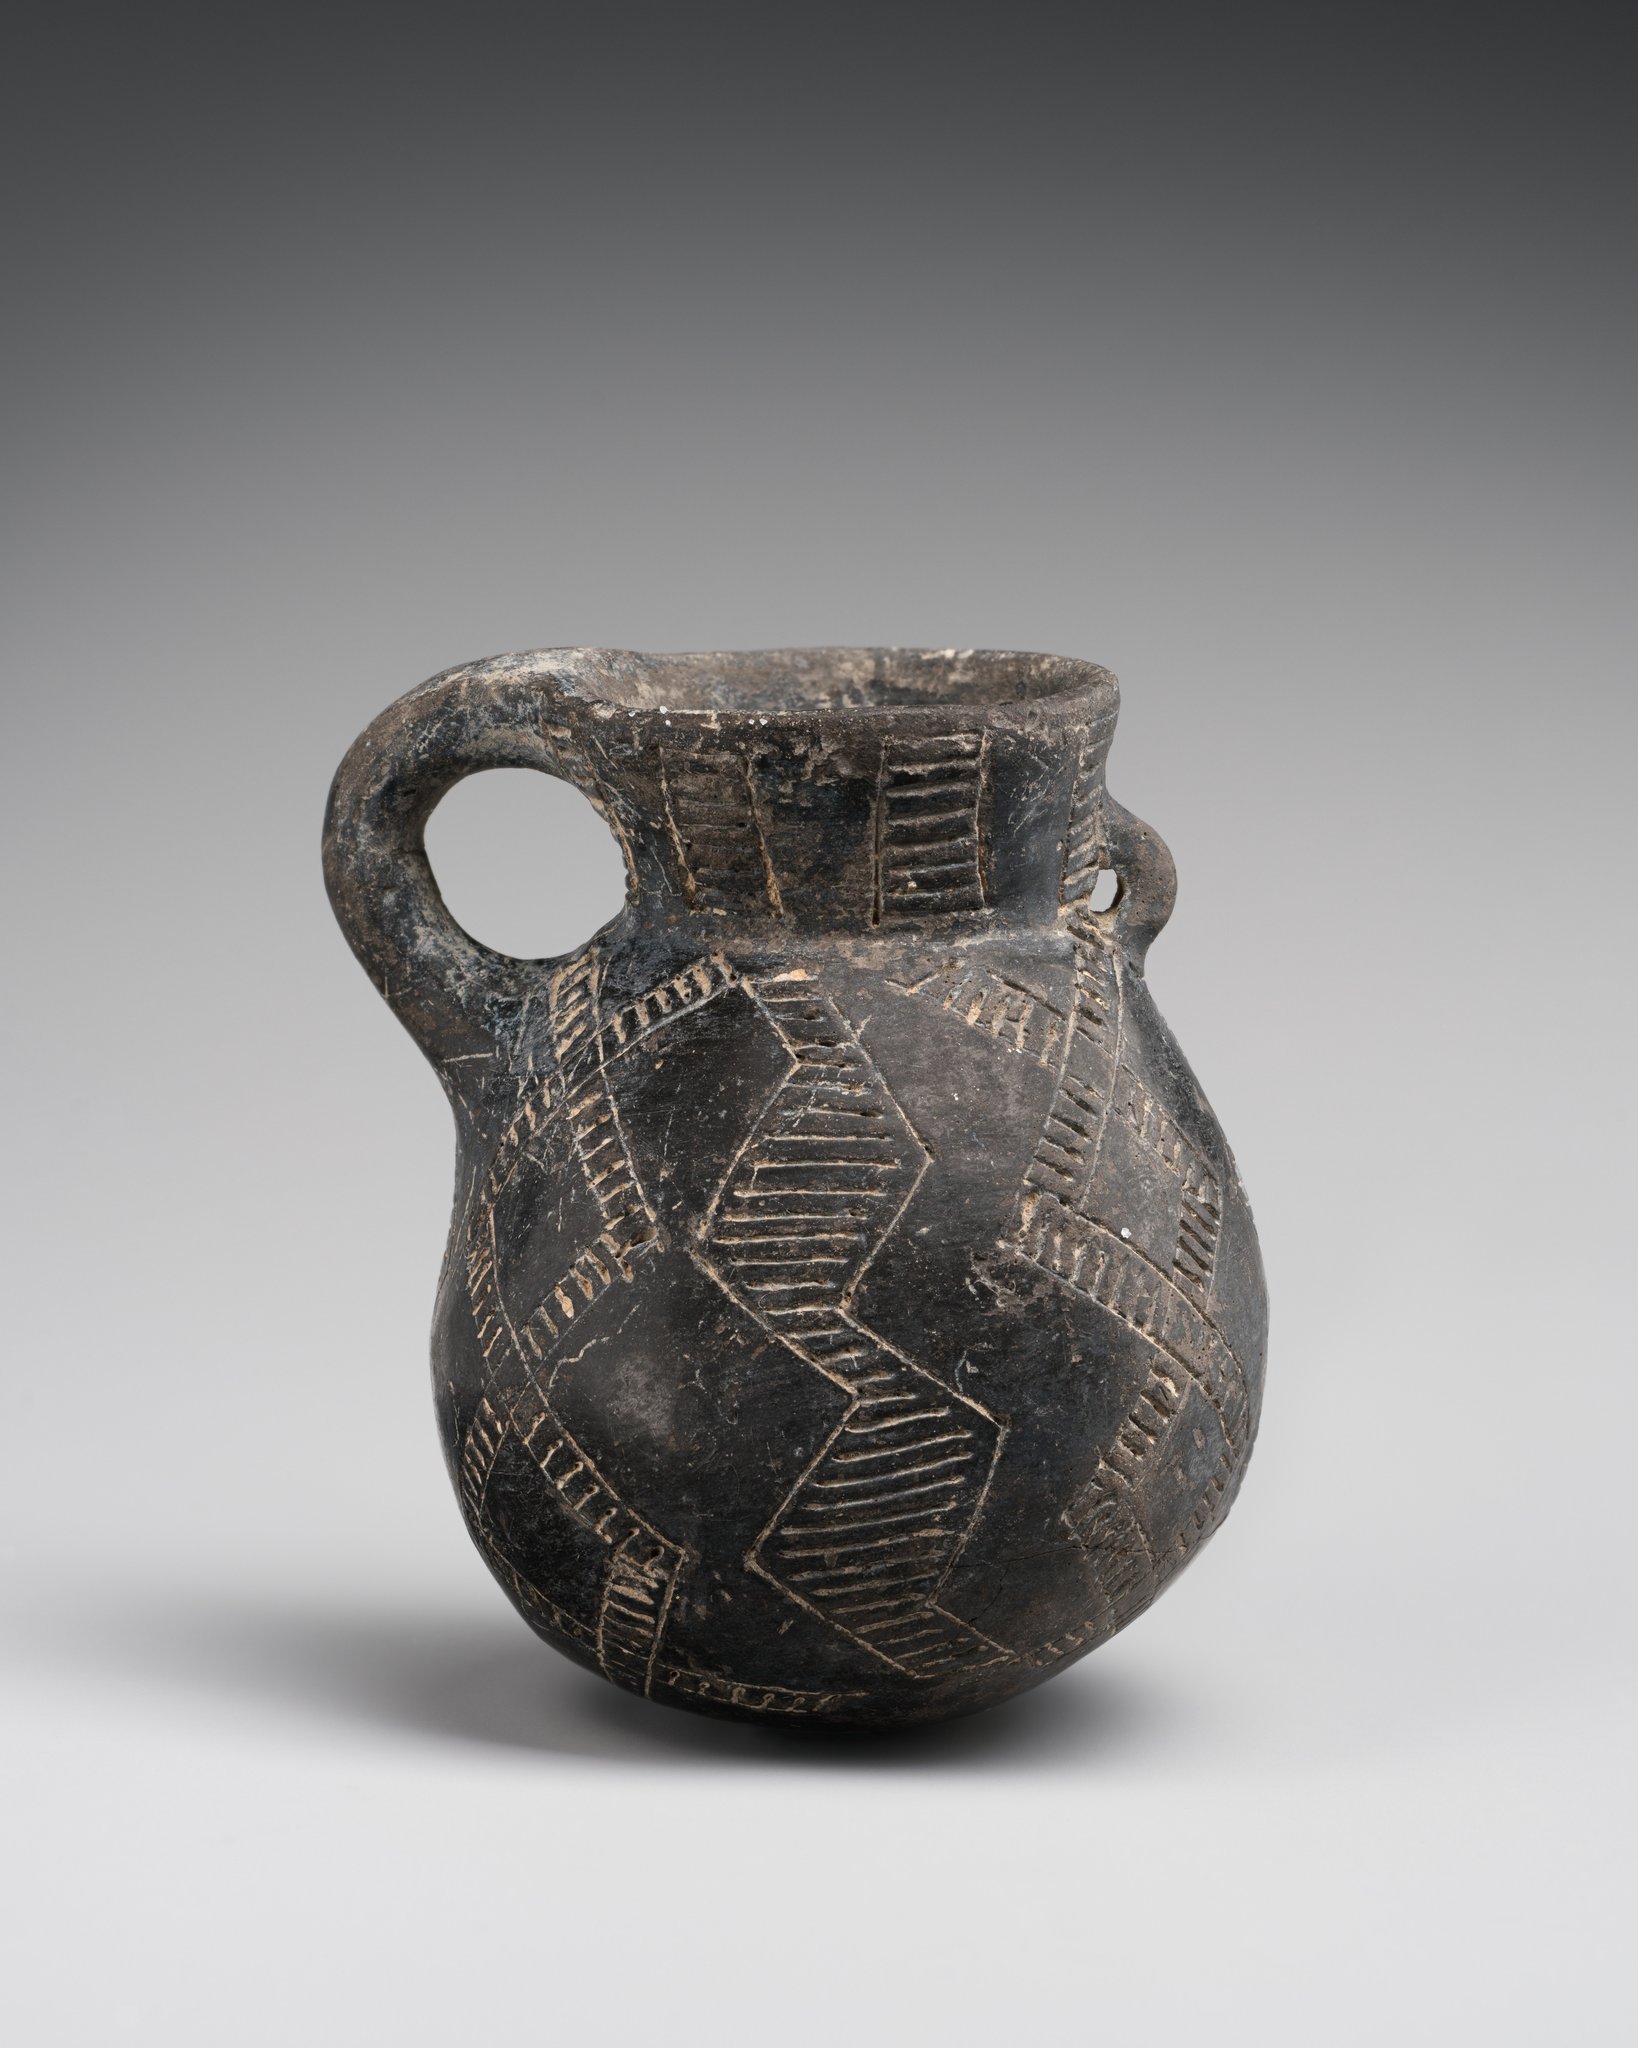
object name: juglet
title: Terracotta juglet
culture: cypriot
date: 1900-1725 BCE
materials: terracotta